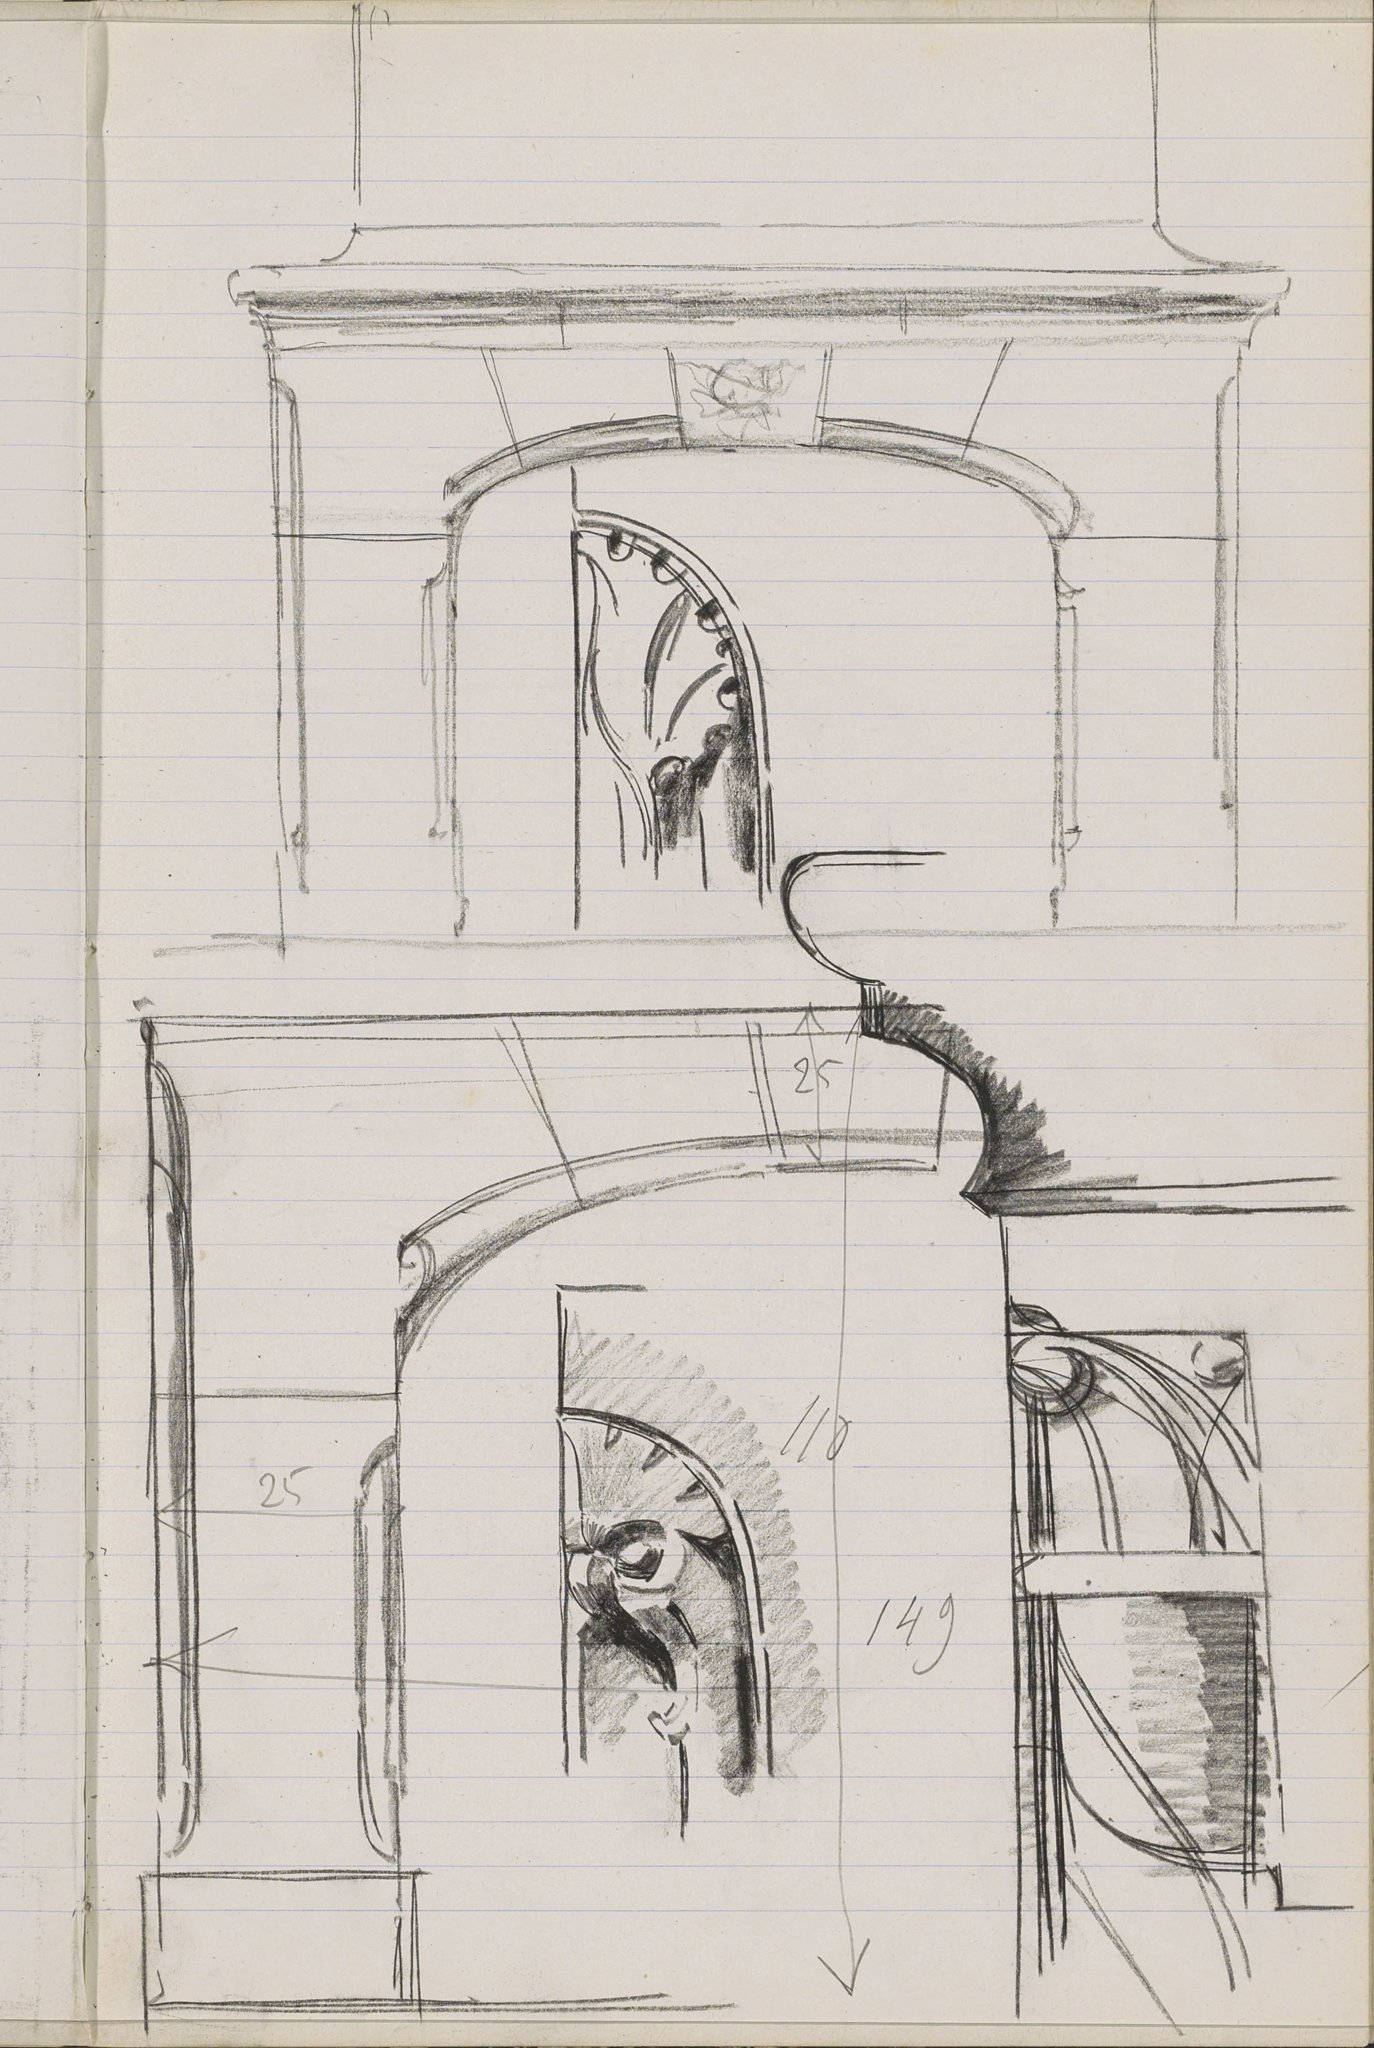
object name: sketchbook leaf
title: Façade van een gebouw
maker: gerrit willem dijsselhof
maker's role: designer, draughtsman, print maker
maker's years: 1866-1924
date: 1901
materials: chalk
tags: exterior ~ representation of a building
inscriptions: annotation: ‘[...]’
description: Blad 37 recto uit een schetsboek met 79 bladen.